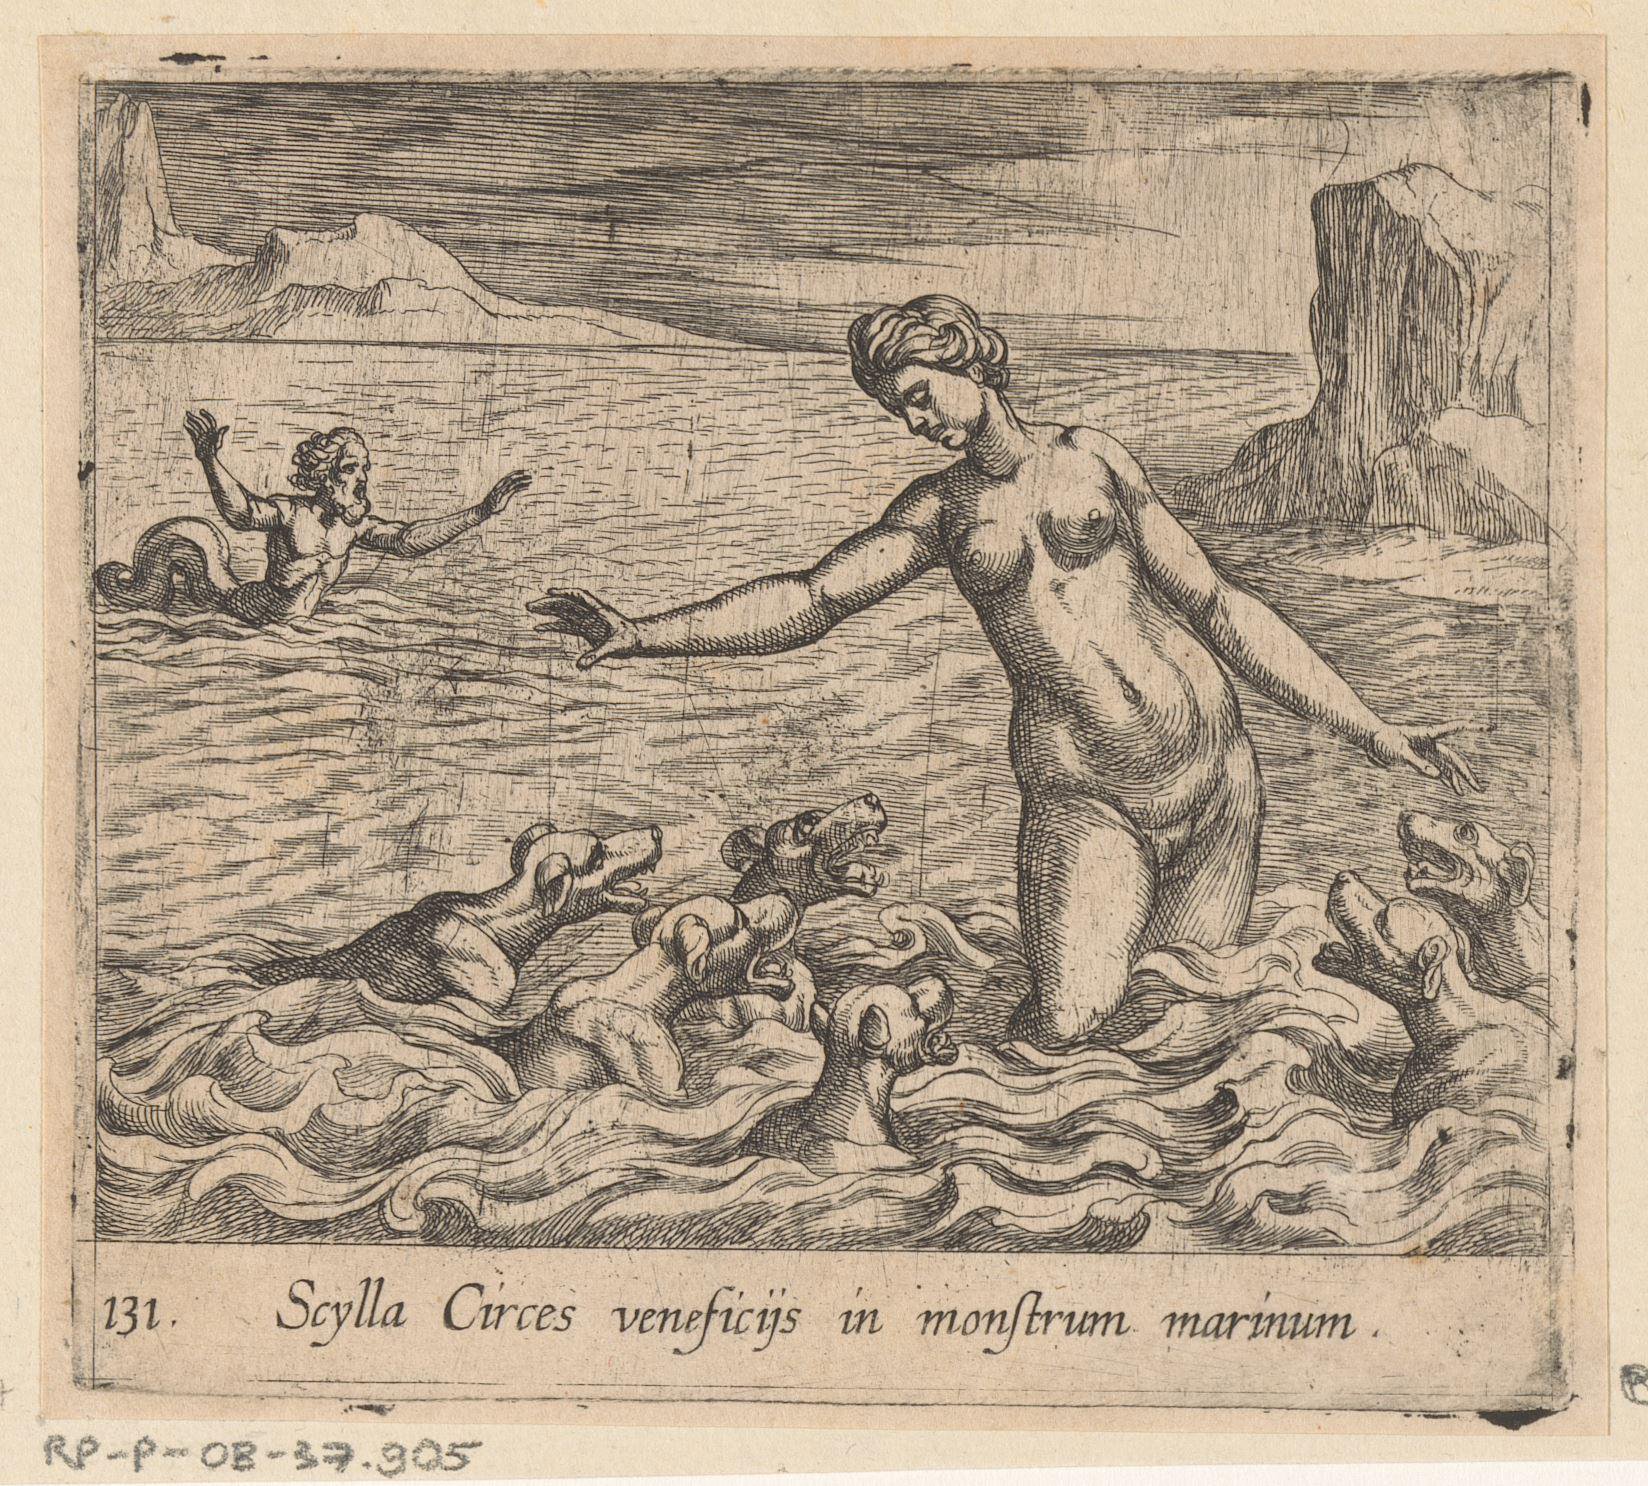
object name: print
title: Metamorfosen van Ovidius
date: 1606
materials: paper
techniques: etching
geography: antwerp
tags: scylla changed into a sea-monster: circe, to whom glaucus has applied for aid in his love suit, changes scylla the sea-nymph into a sea-monster (ovid, metamorphoses xiv 59)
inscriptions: collector's mark: Lugt 240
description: Scylla wordt door Circe in een zeemonster veranderd op verzoek van Glaucus. Scylla staat in de zee en wordt omringd door honden. Titel in het Latijn in ondermarge.